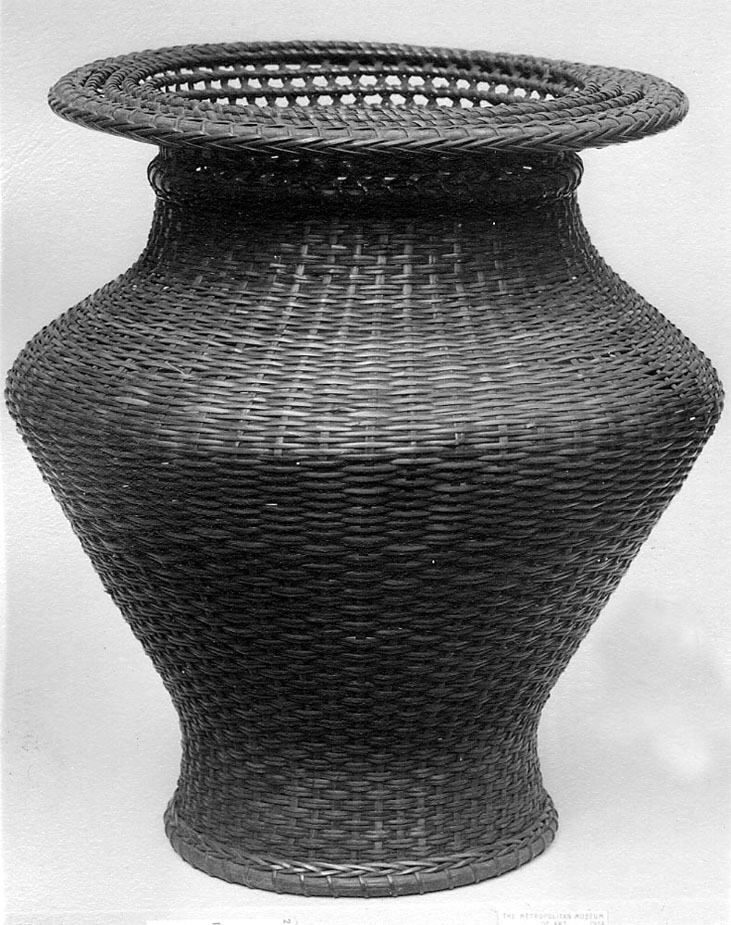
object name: basket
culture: japanese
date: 1801-1900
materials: bamboo